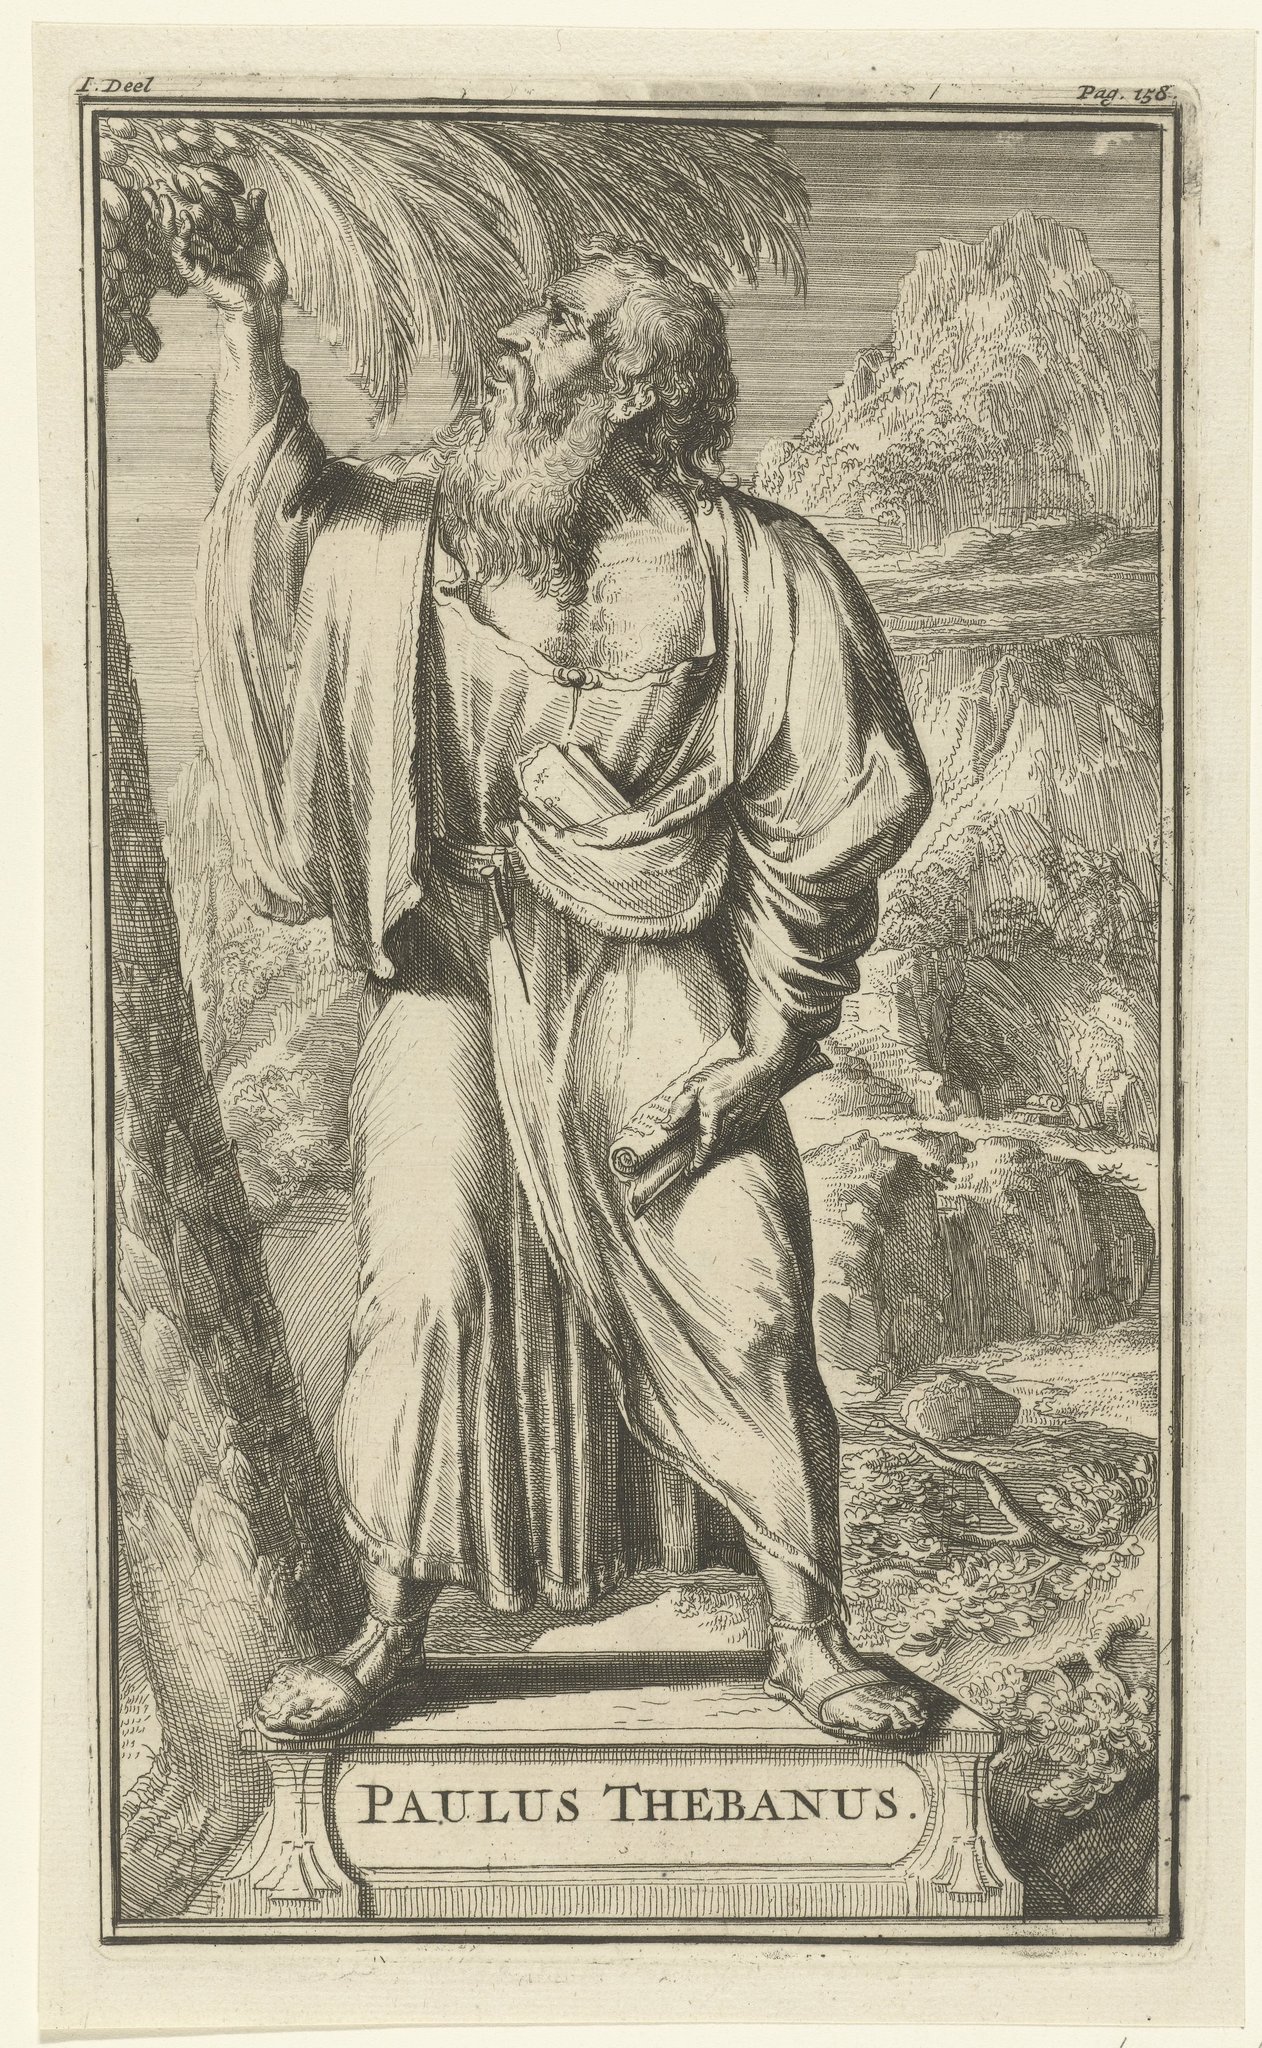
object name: print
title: Historie der Kerken en ketteren (...) tot aan het jaar onses Heeren 1688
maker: romeyn de hooghe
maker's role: draughtsman, goldsmith, painter, print maker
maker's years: 1645-1708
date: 1701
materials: paper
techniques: engraving, etching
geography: netherlands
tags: paulus thebanus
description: Portret van Sint Paul van Thebe uit een serie portretten in Historie der Kerken en ketteren van den beginne des Nieuwen Testaments tot aan het jaar onses Heeren 1688 van Godfried Arnold (1701).